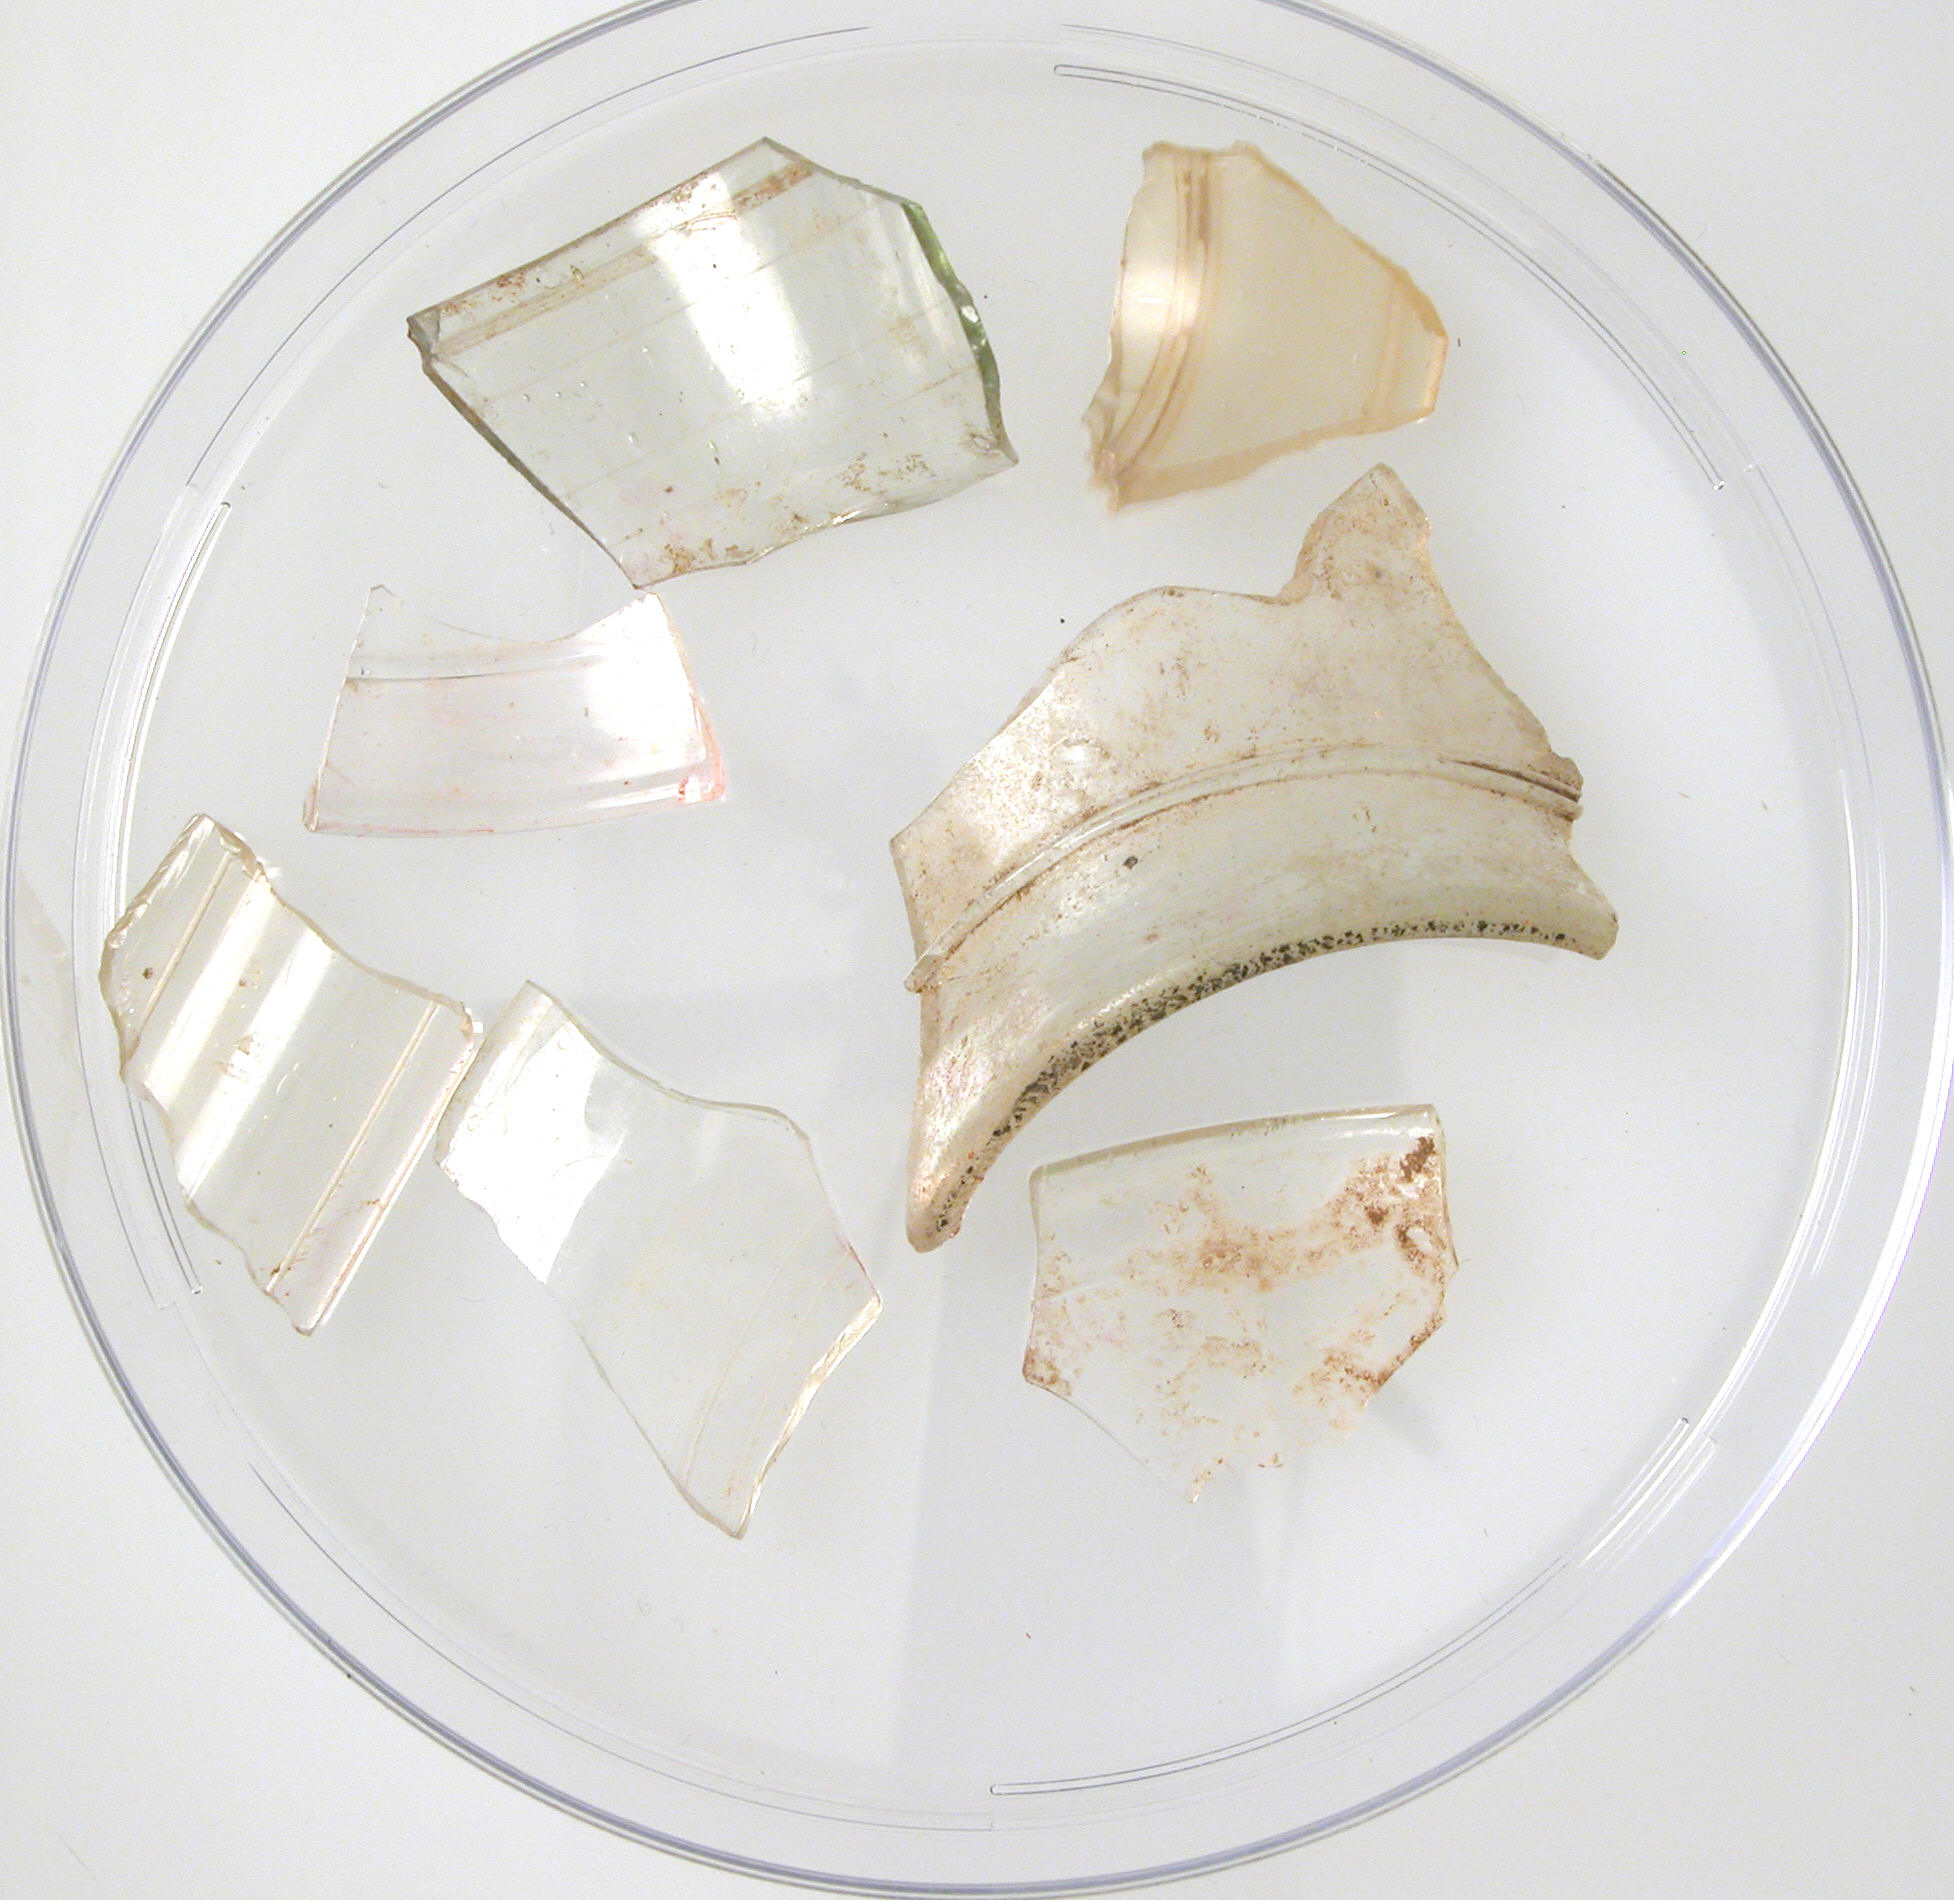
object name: fragment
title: Glass Fragments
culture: coptic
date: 301-433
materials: glass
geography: egypt